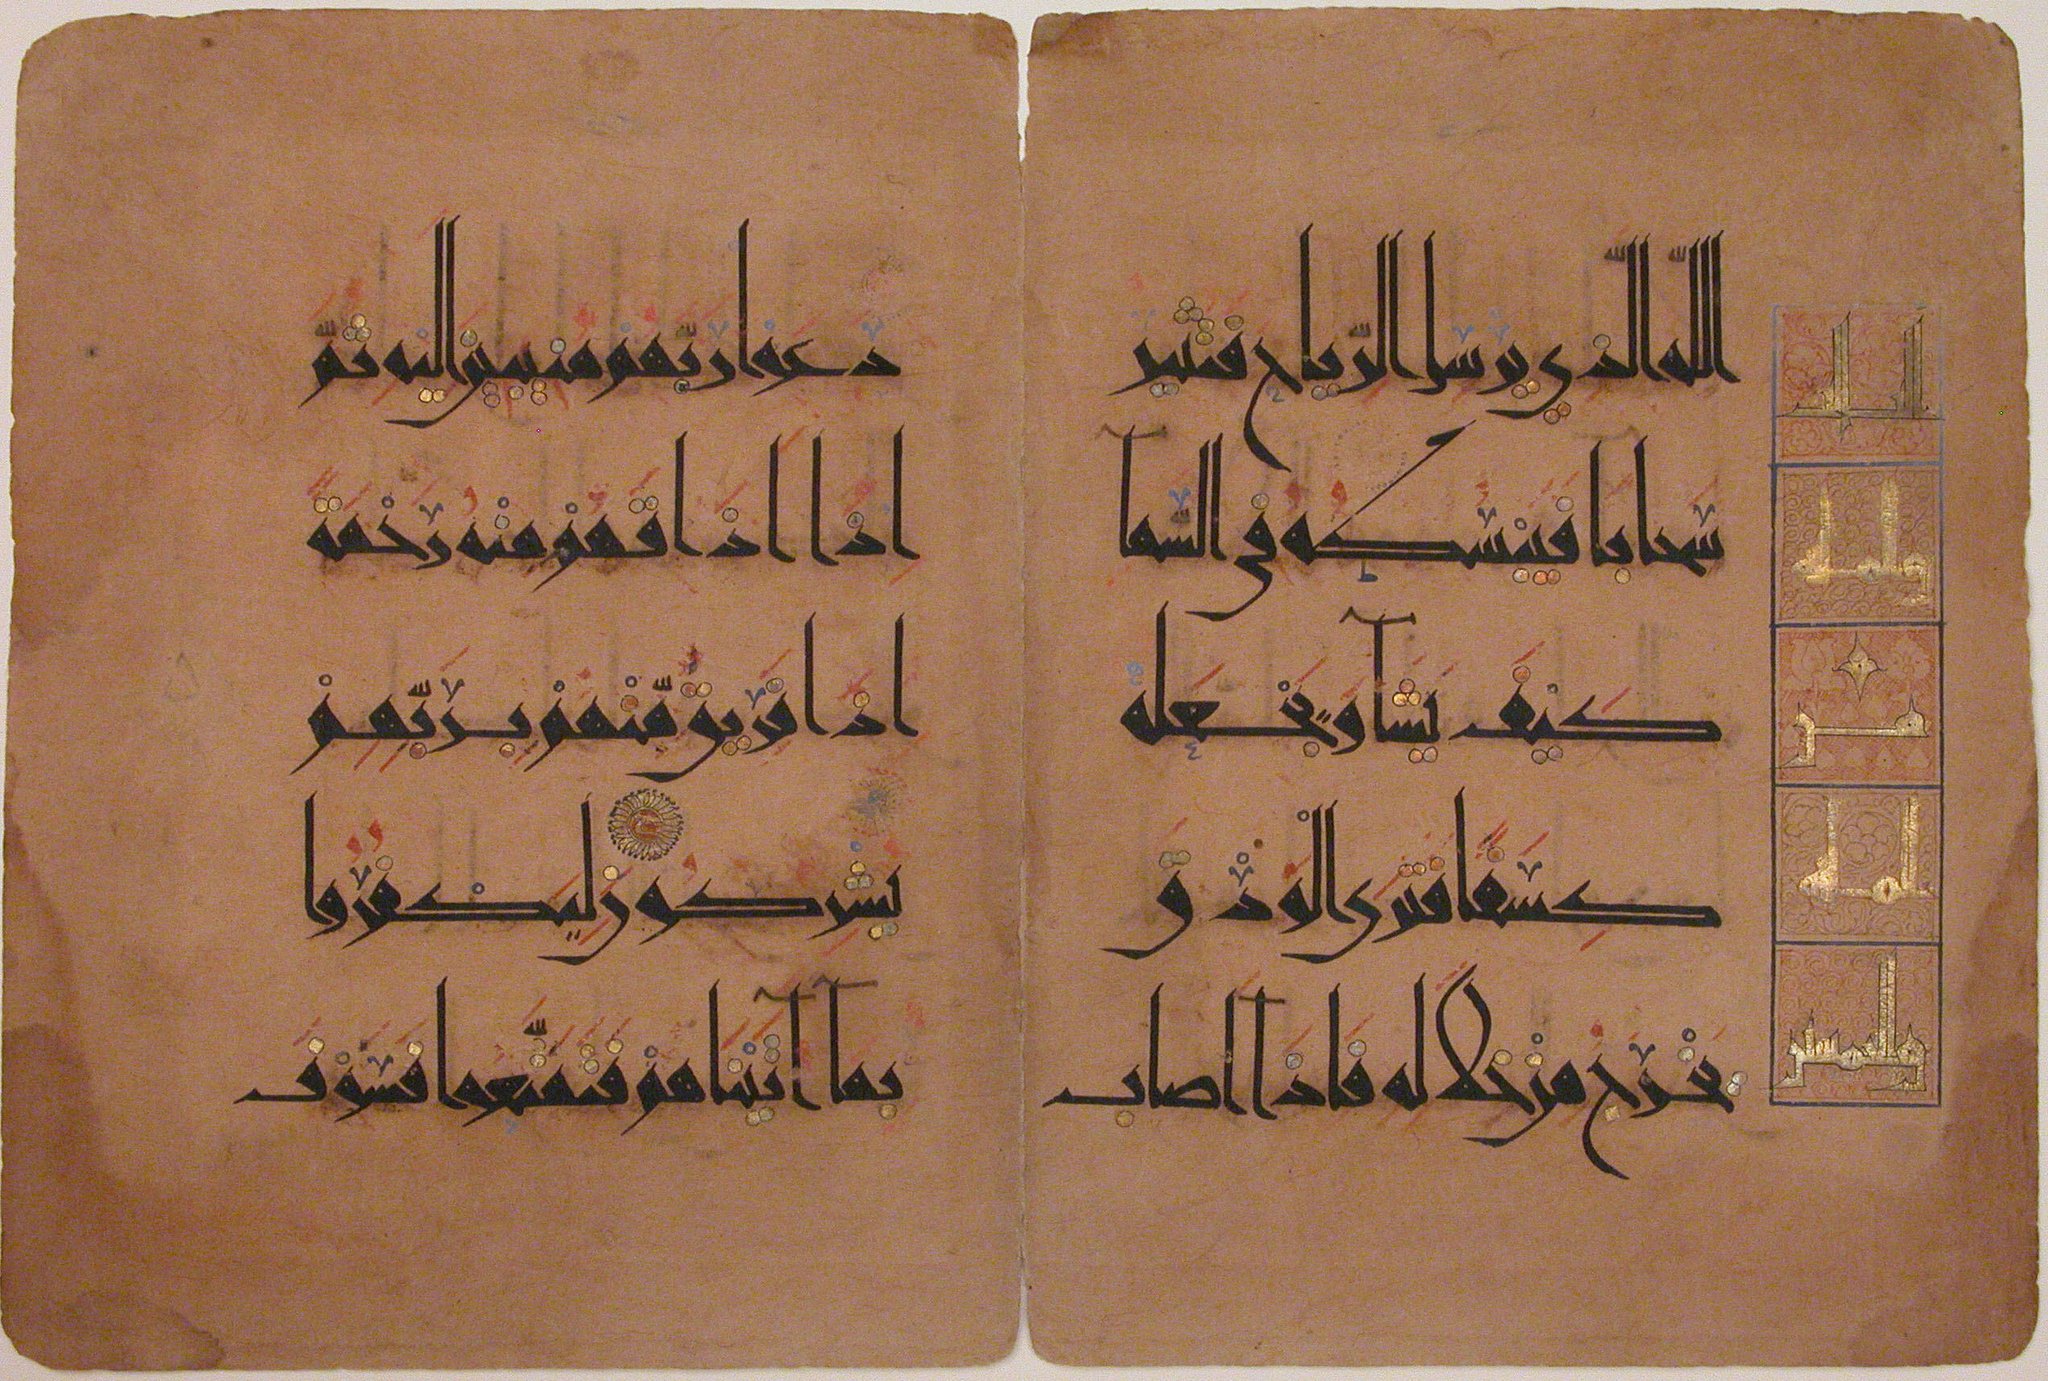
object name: folio from a non illustrated manuscript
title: Folio from a Qur'an Manuscript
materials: gold, ink, paper, watercolor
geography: afghanistan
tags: qur'an,calligraphy